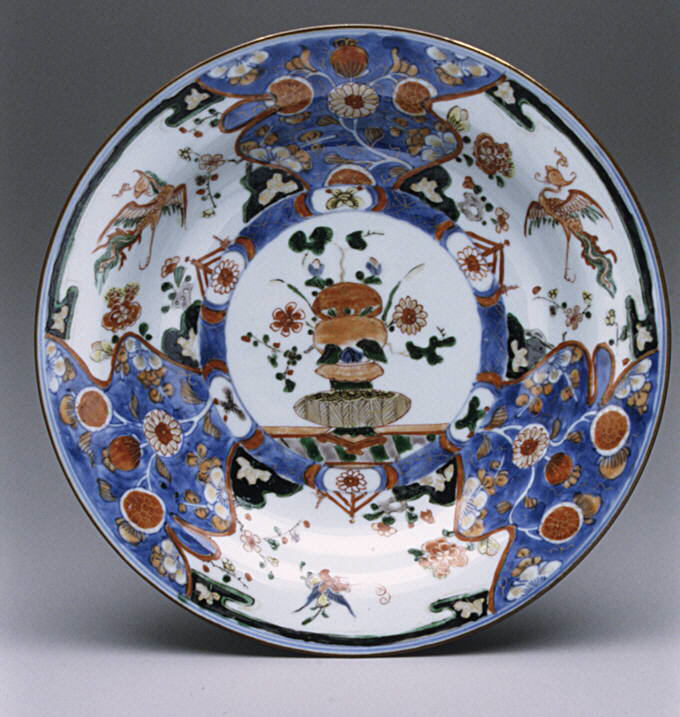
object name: dish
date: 1720-1725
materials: hard paste porcelain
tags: birds,flowers